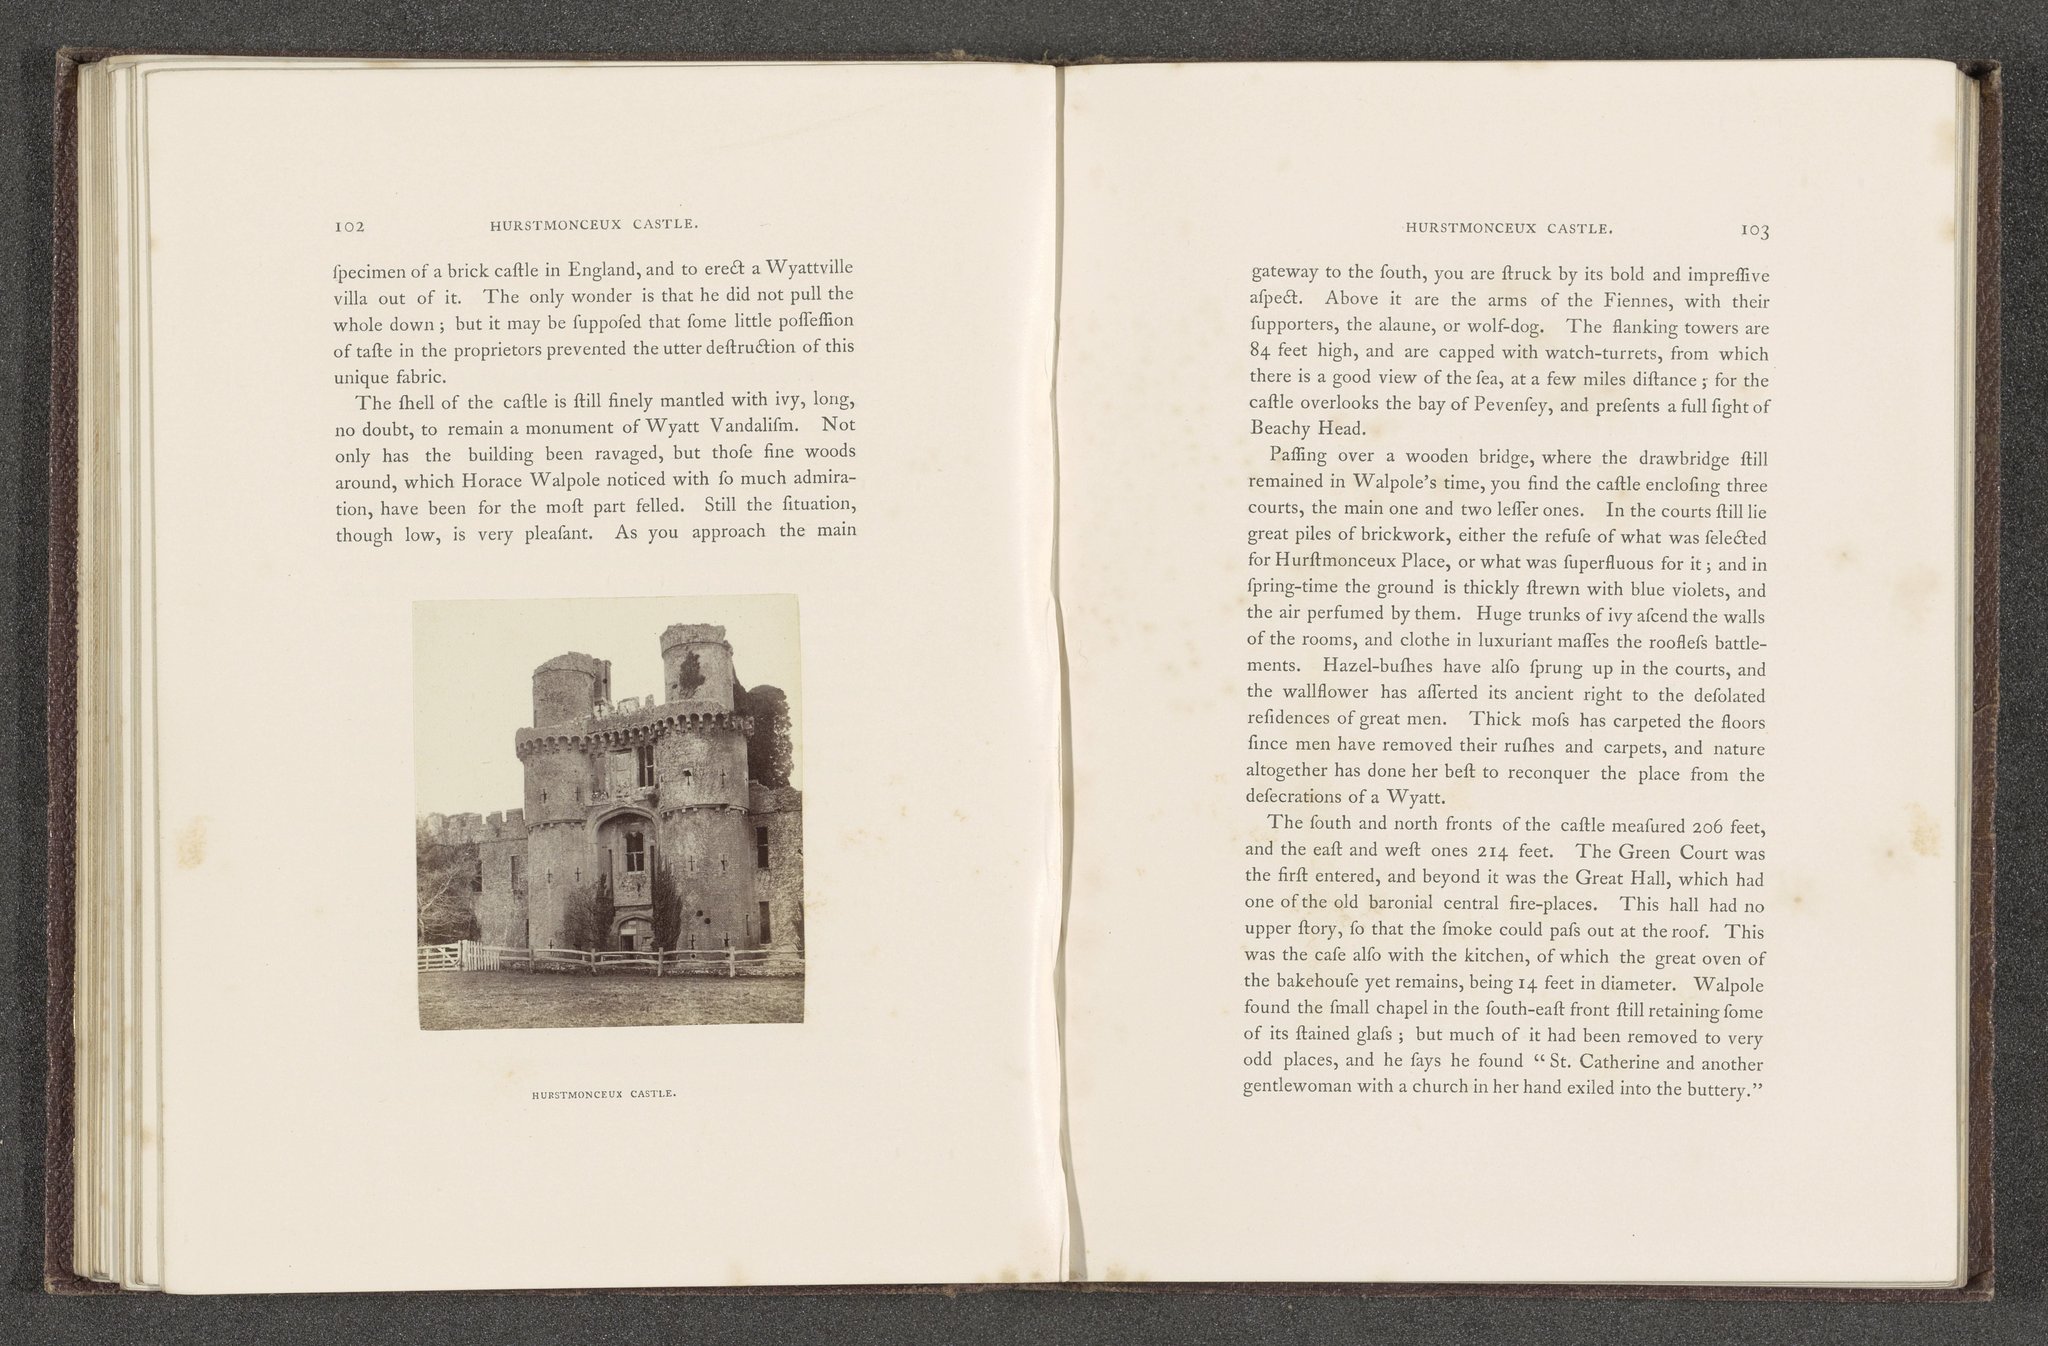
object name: photograph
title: Hurstmonceux Castle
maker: william russell sedgfield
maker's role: fotograaf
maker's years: 1826-1902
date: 1854-1864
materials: photographic support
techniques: albumen print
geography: herstmonceux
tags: ruin of a dwelling, house, castle, etc.